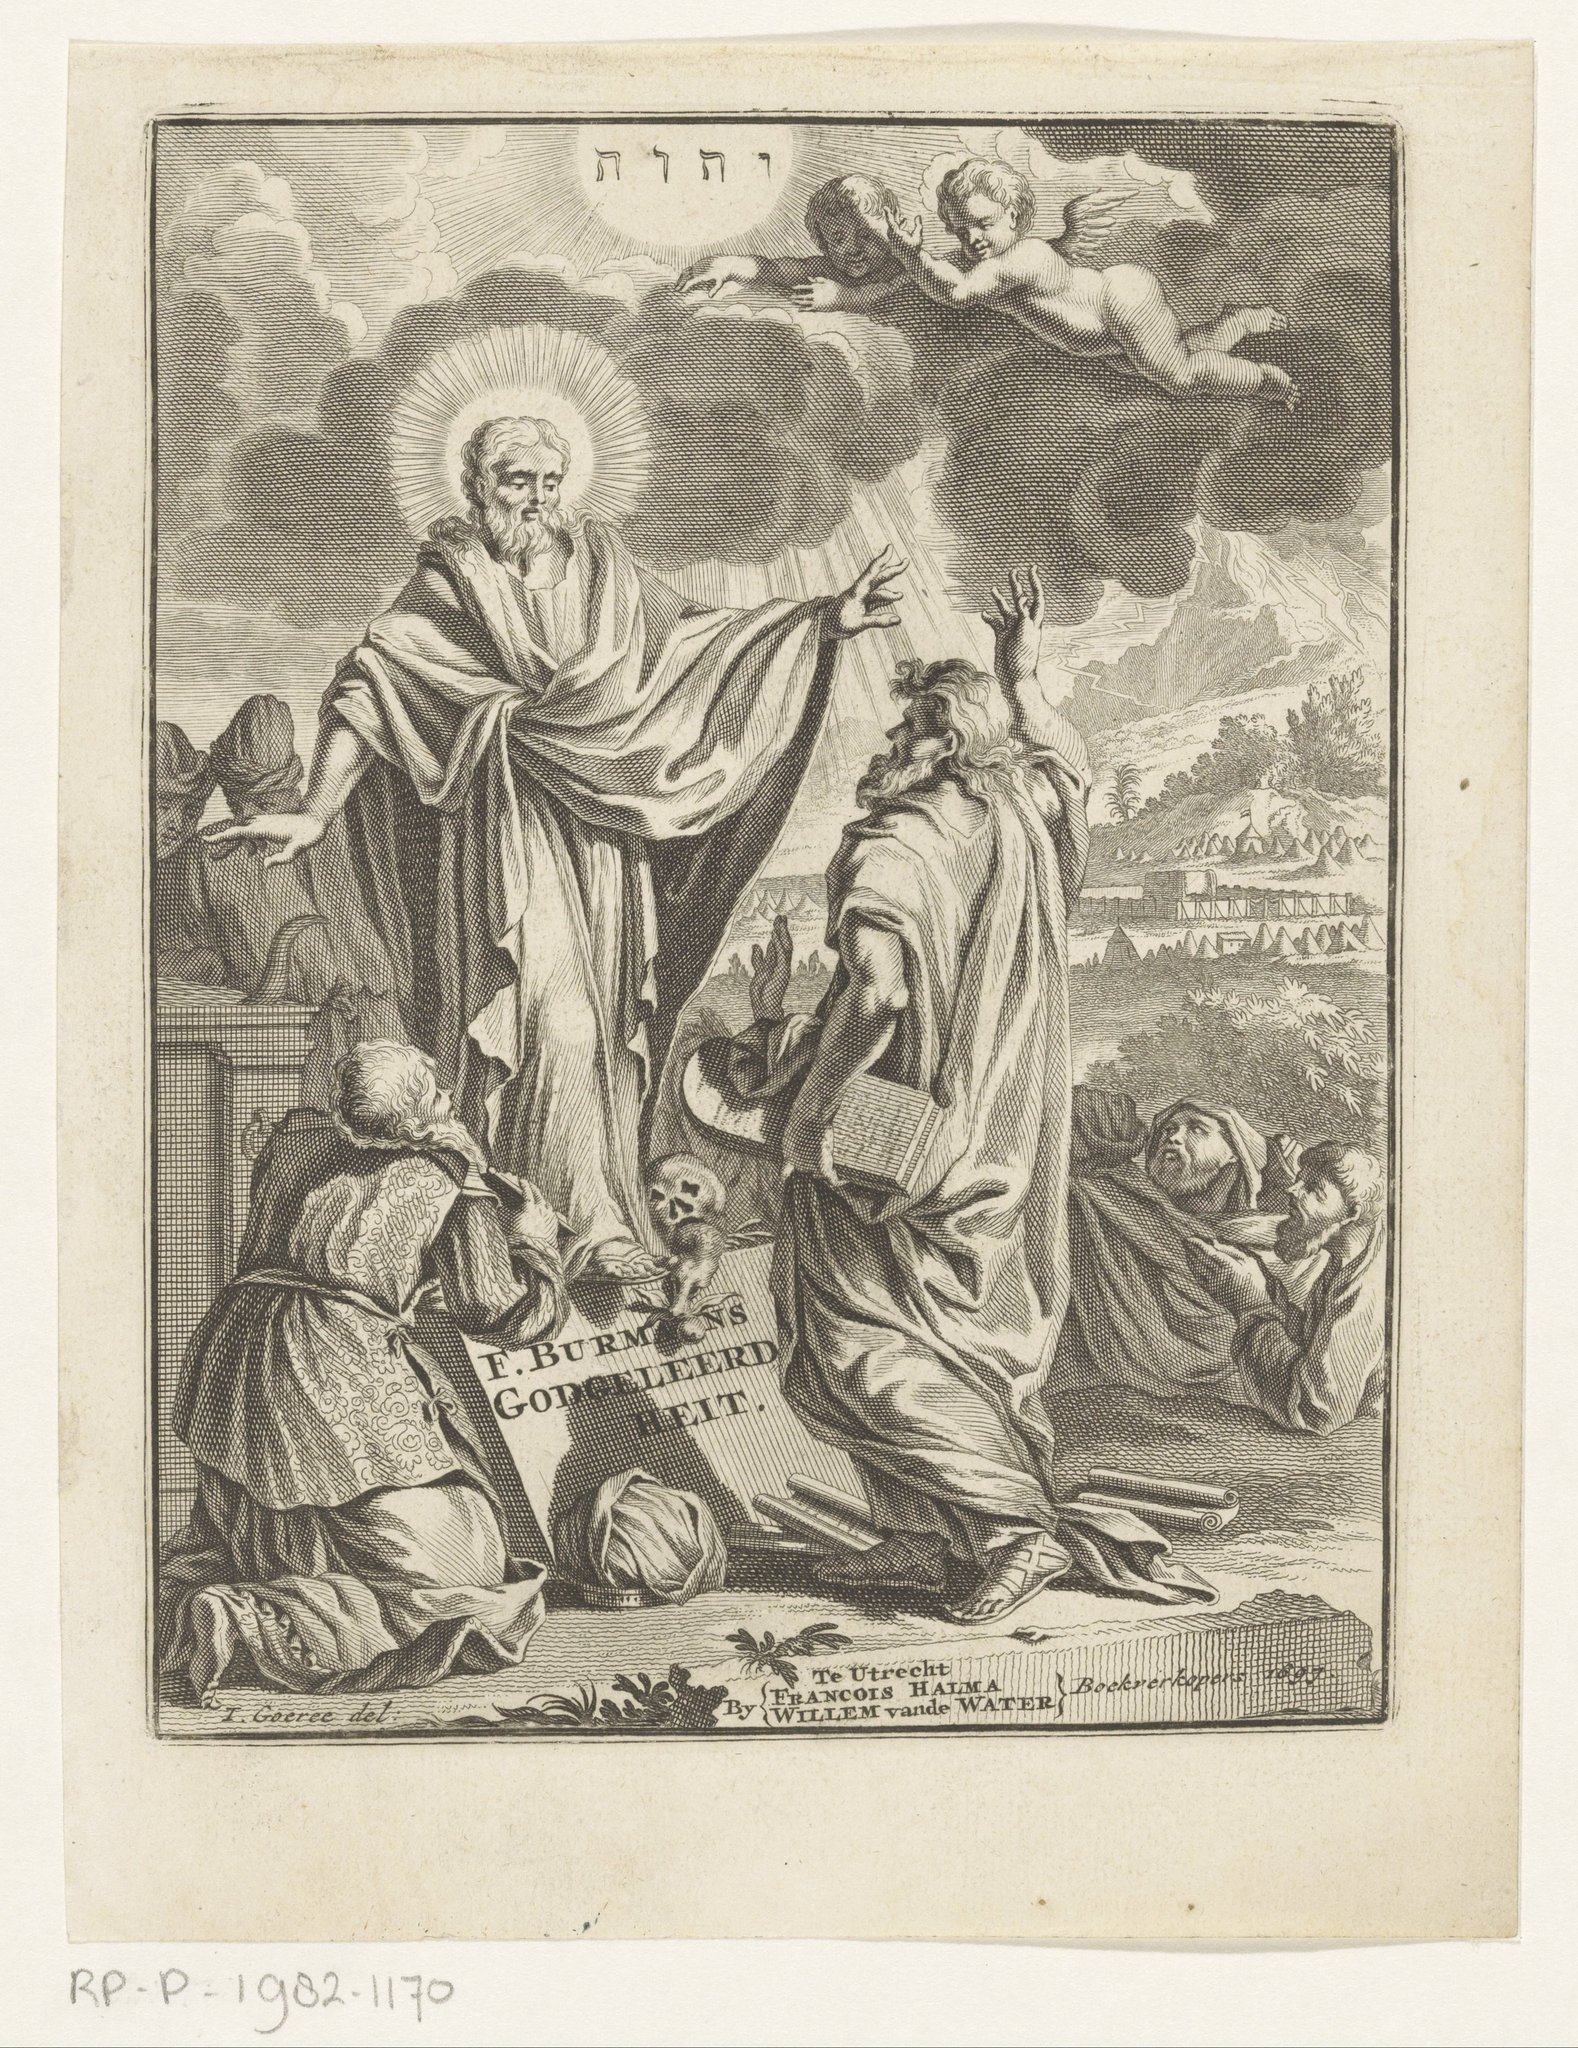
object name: print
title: Titelpagina voor: Frans Burman, Godgeleerdheit, 1697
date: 1697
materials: paper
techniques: engraving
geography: utrecht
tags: christ, moses (not in biblical context); possible attributes: rays of light or horns on his head, rod, tables of the law, kneeling figure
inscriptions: collector's mark: Lugt 2760, collector's mark: Lugt 2228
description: Christus staat op een steen met de boektitel. Voor hem staat Mozes met de stenen tafelen, zijn rechterhand in de lucht geheven. Links presenteert een knielende man, mogelijk de schrijver, een open boek aan Christus. Rondom kijkt een groep mannen toe.